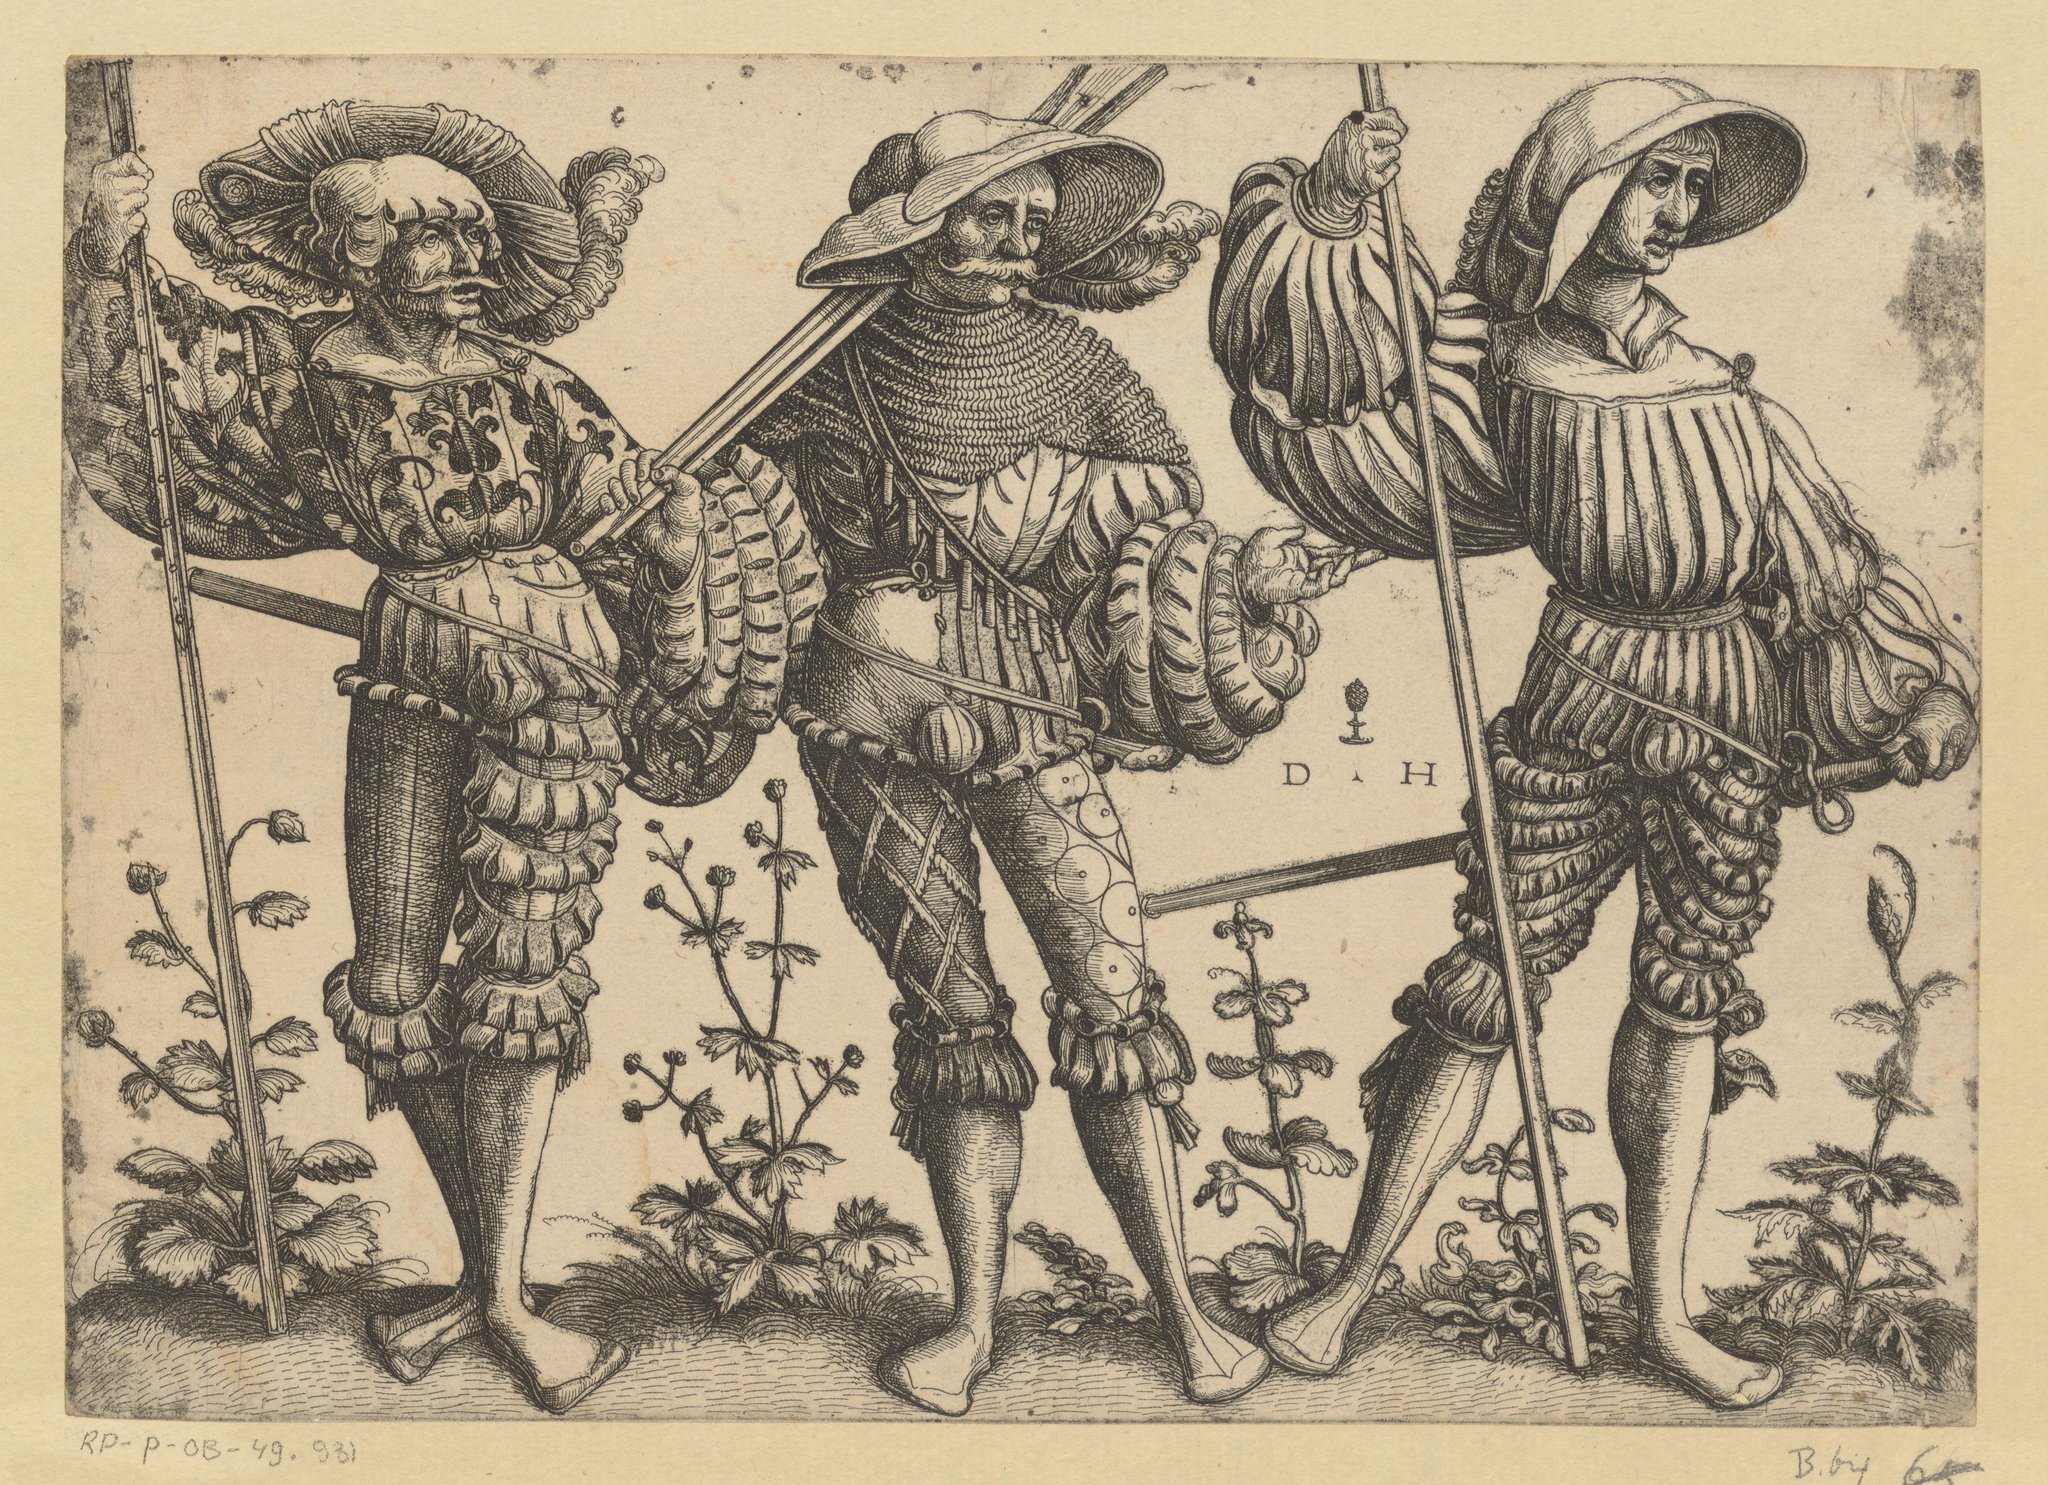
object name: print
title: Drie landsknechten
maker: daniel hopfer (i)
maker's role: print maker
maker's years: 1470-1536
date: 1504-1536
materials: paper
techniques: etching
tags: the soldier; the soldier's life, (military) uniforms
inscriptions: collector's mark: Lugt 240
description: Deze prent maakt deel uit van een serie van drie prenten met 'Landsknechten' als thema. Enkele figuren uit prenten in deze serie zijn mogelijk geïnspireerd op houtsnedes van Erhard Schön, ontworpen door Peter Flötner. (Metzger, 2009)